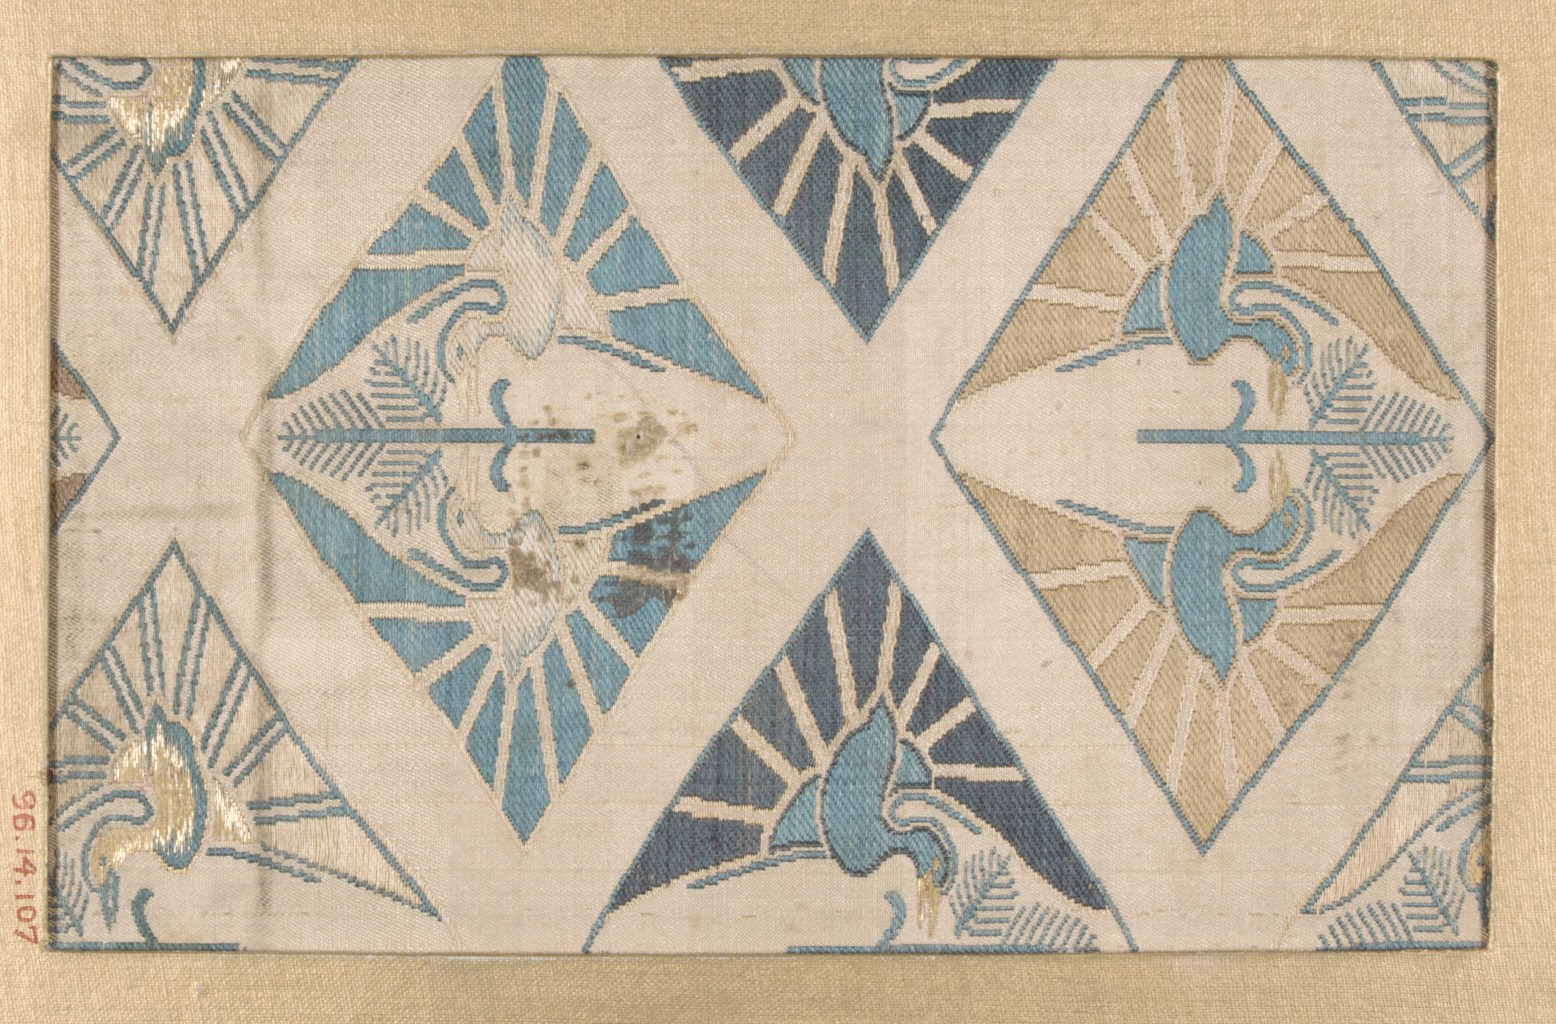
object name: piece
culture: japanese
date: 1701-1900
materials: silk